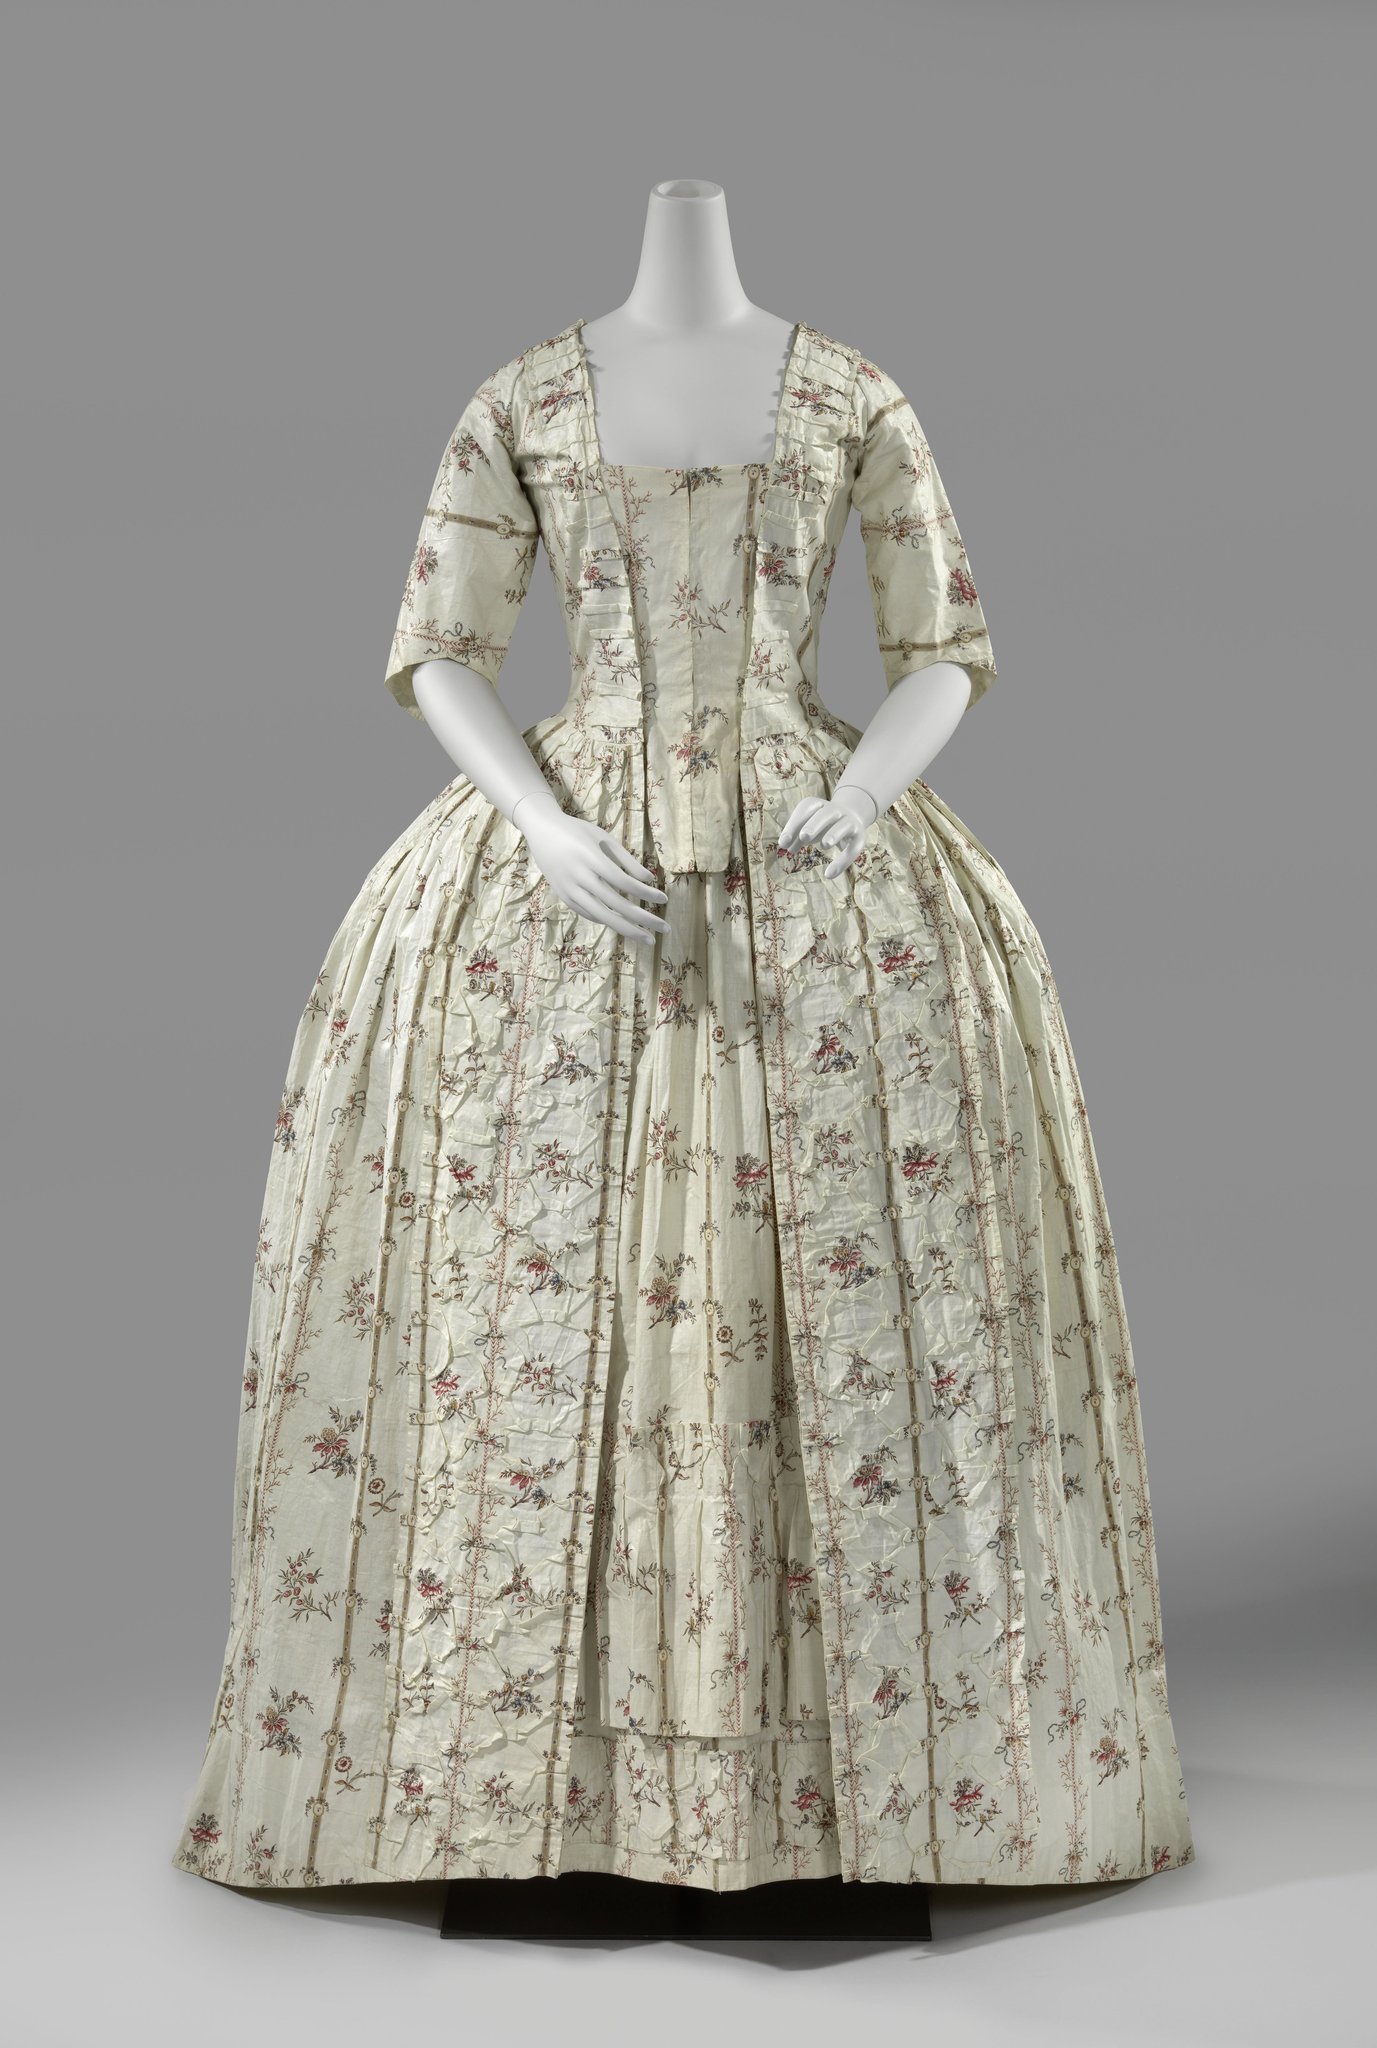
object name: main garment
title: Dress Made of Printed Fabric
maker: Anonymous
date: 1775-1785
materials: textile, cotton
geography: netherlands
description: The dress is made of cotton with a glazed finish produced in Europe. This kind of European fabric, which was often printed, was a less expensive alternative to chintz, a handpainted or stained calico cloth imported from India. The dress on view is adorned with panels of the same fabric with pleats folded into a hexagonal pattern.